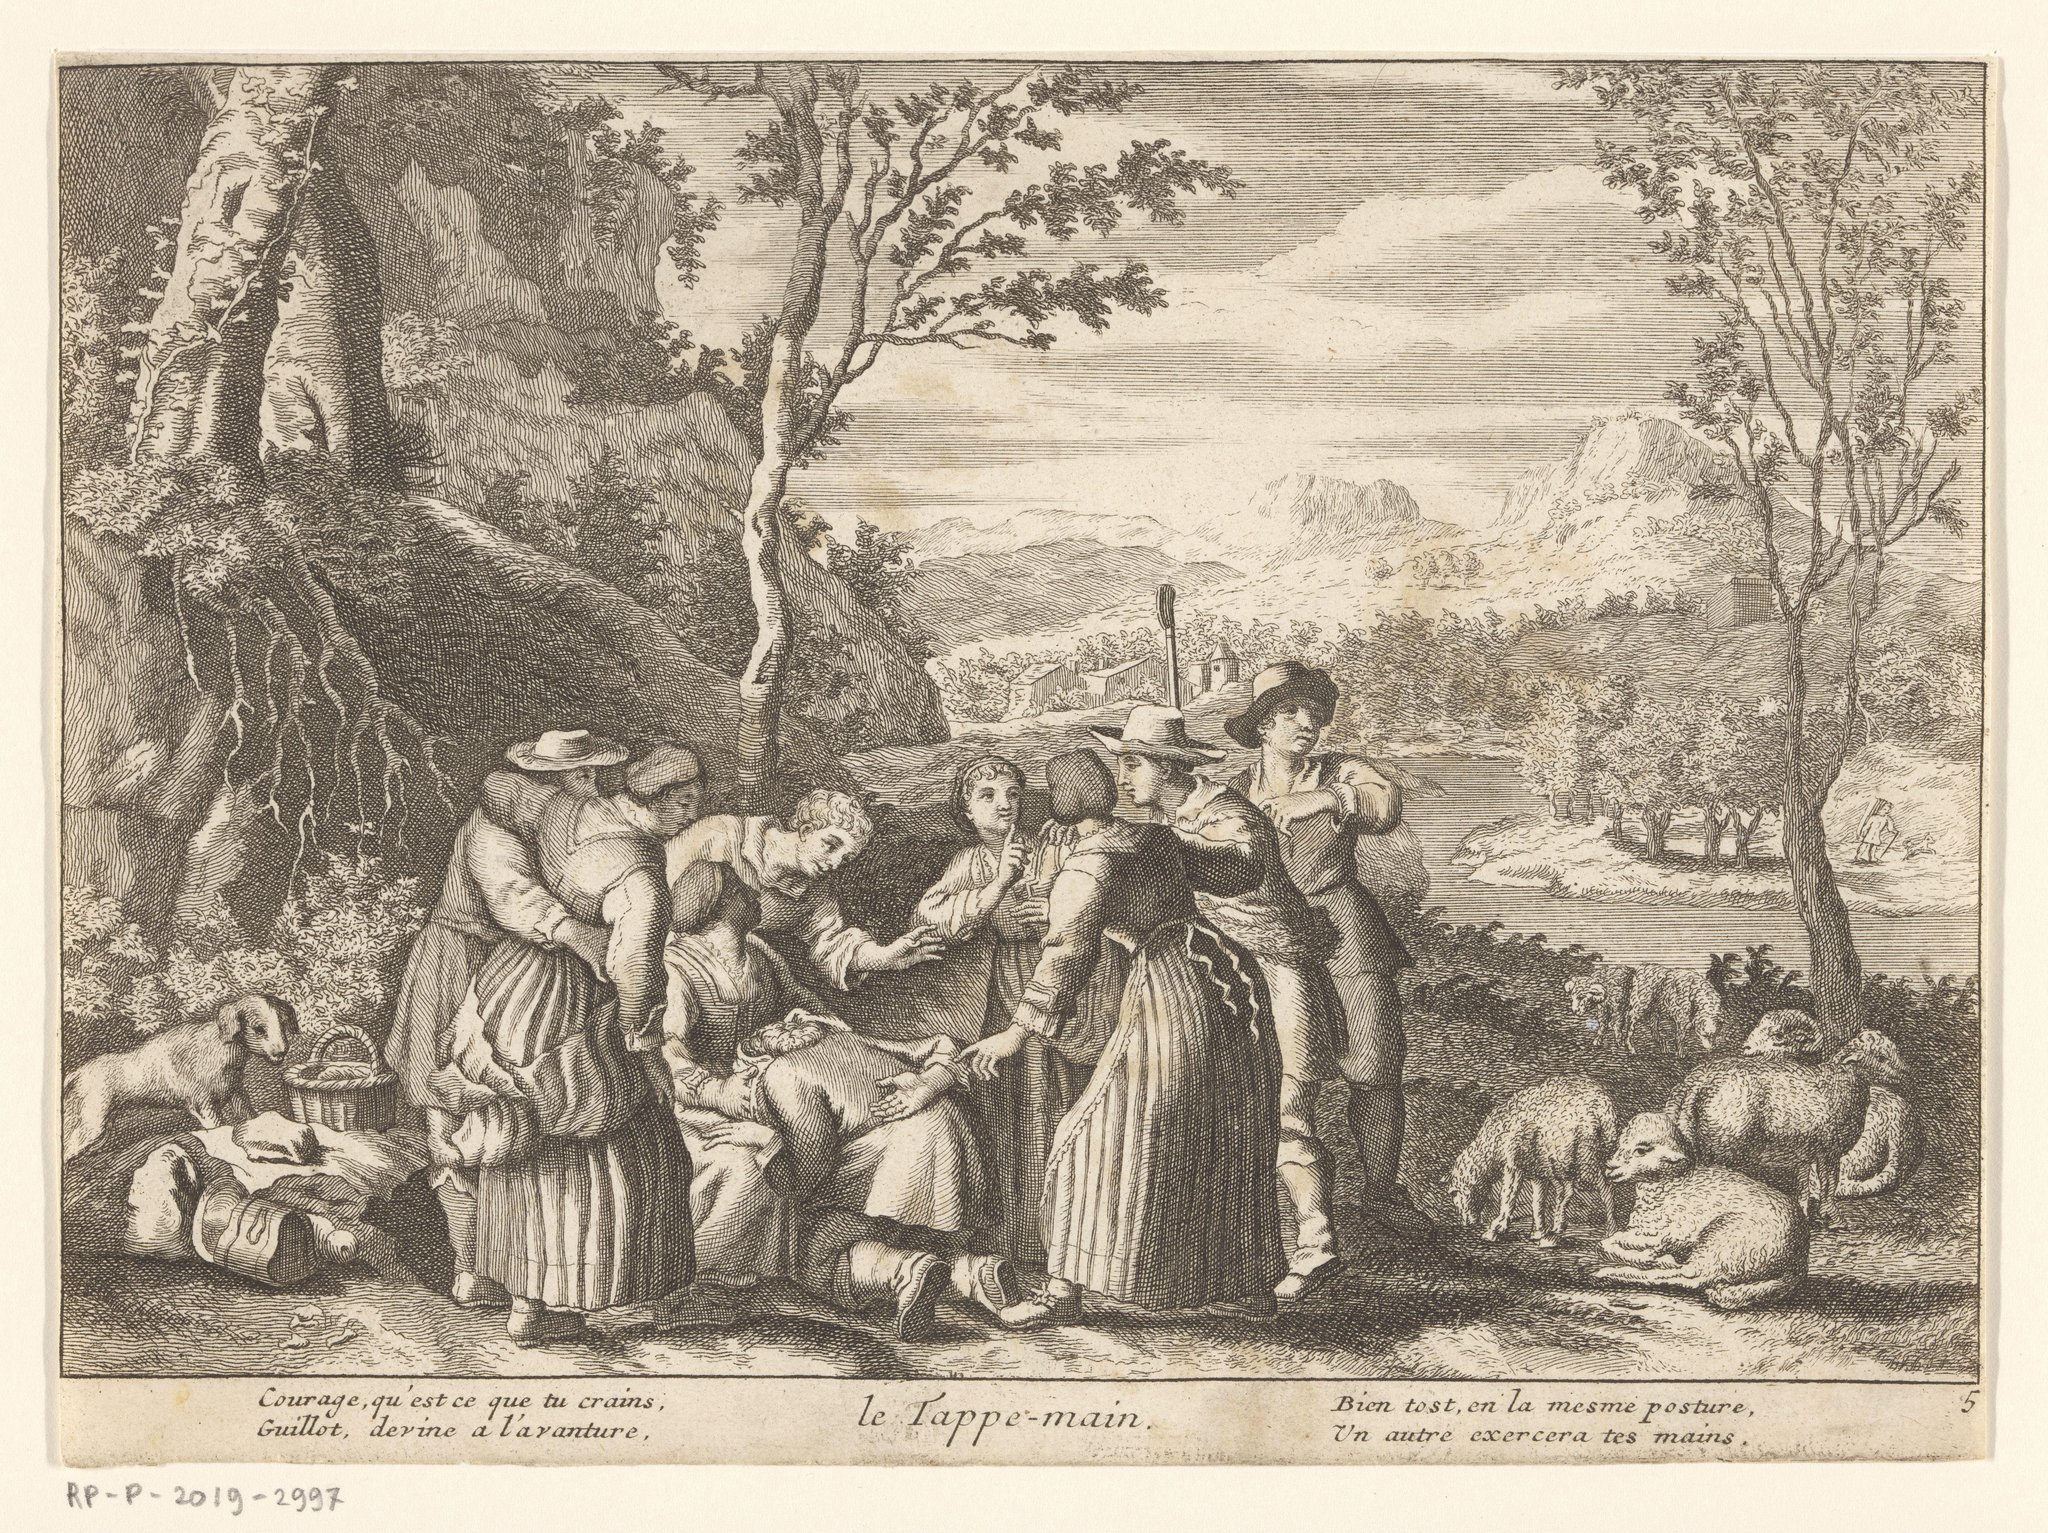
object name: print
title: Figuren een spelen een spel blindeman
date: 1661-1726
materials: paper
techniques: engraving, etching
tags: hot cockles, 'haute coquilles', 'la main chaude' (party game)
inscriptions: collector's mark: Lugt 2228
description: Maakt deel uit van een zestiendelige serie met landelijke en pastorale scènes, uitgegeven door Gerard Valck.